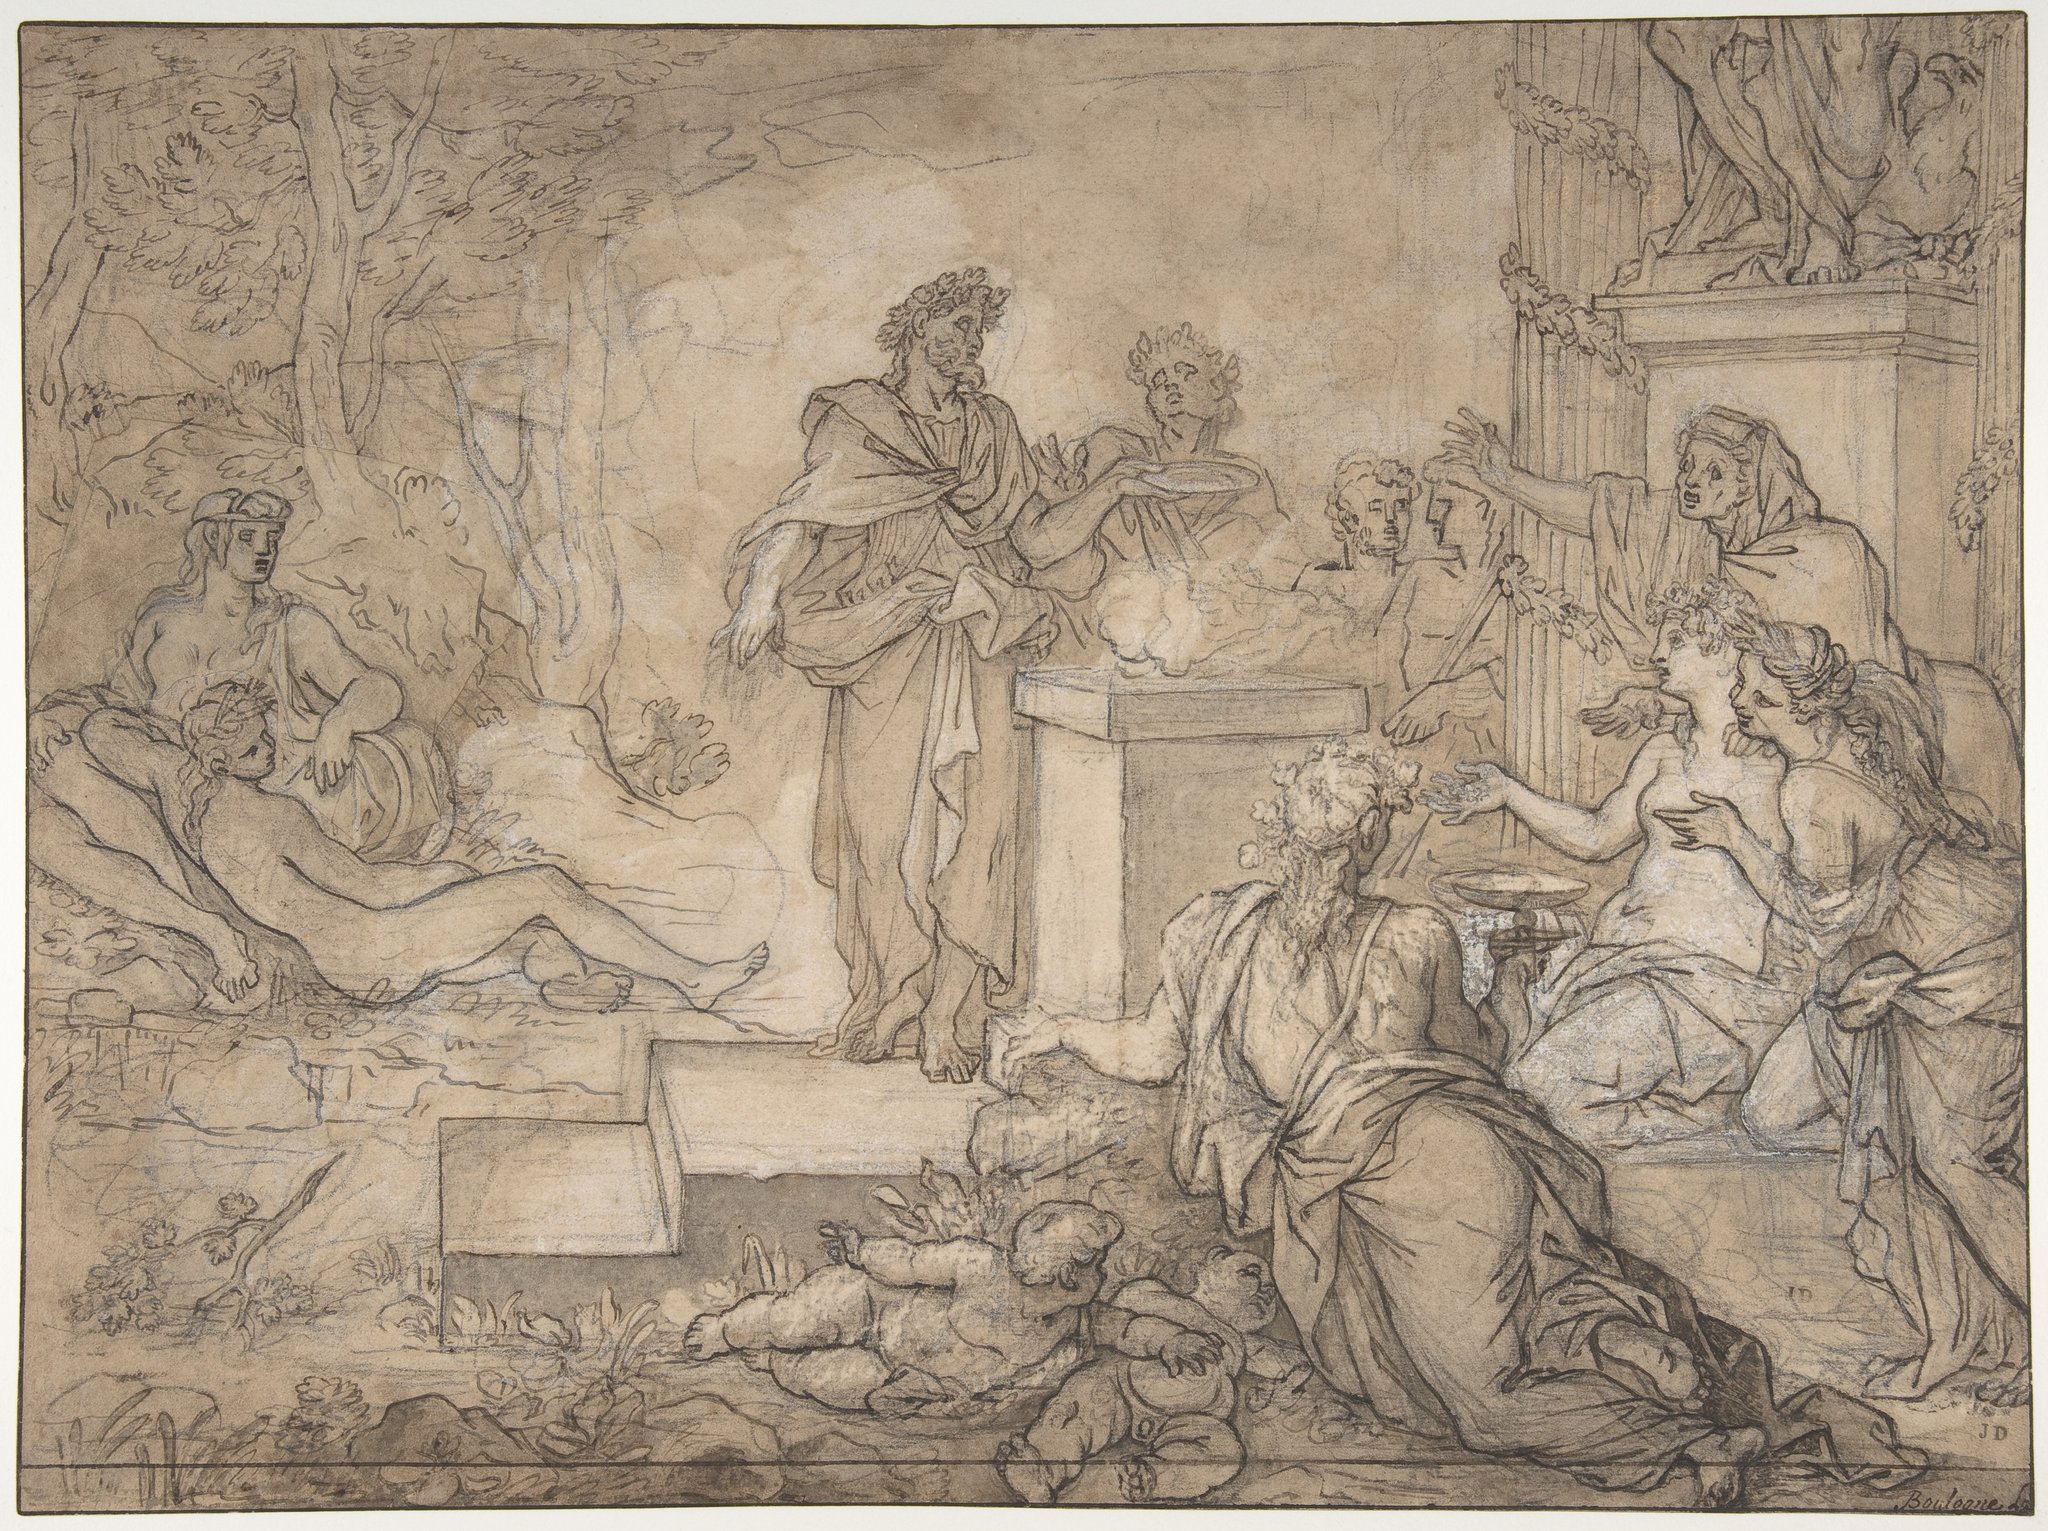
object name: drawing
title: Sacrifice Offered before a Statue of Jupiter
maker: louis de boullogne the elder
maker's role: artist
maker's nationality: french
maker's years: 1609-1674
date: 1601-1700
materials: chalk, gouache, ink, paper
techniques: cutting, heightening, pen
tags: women,jupiter